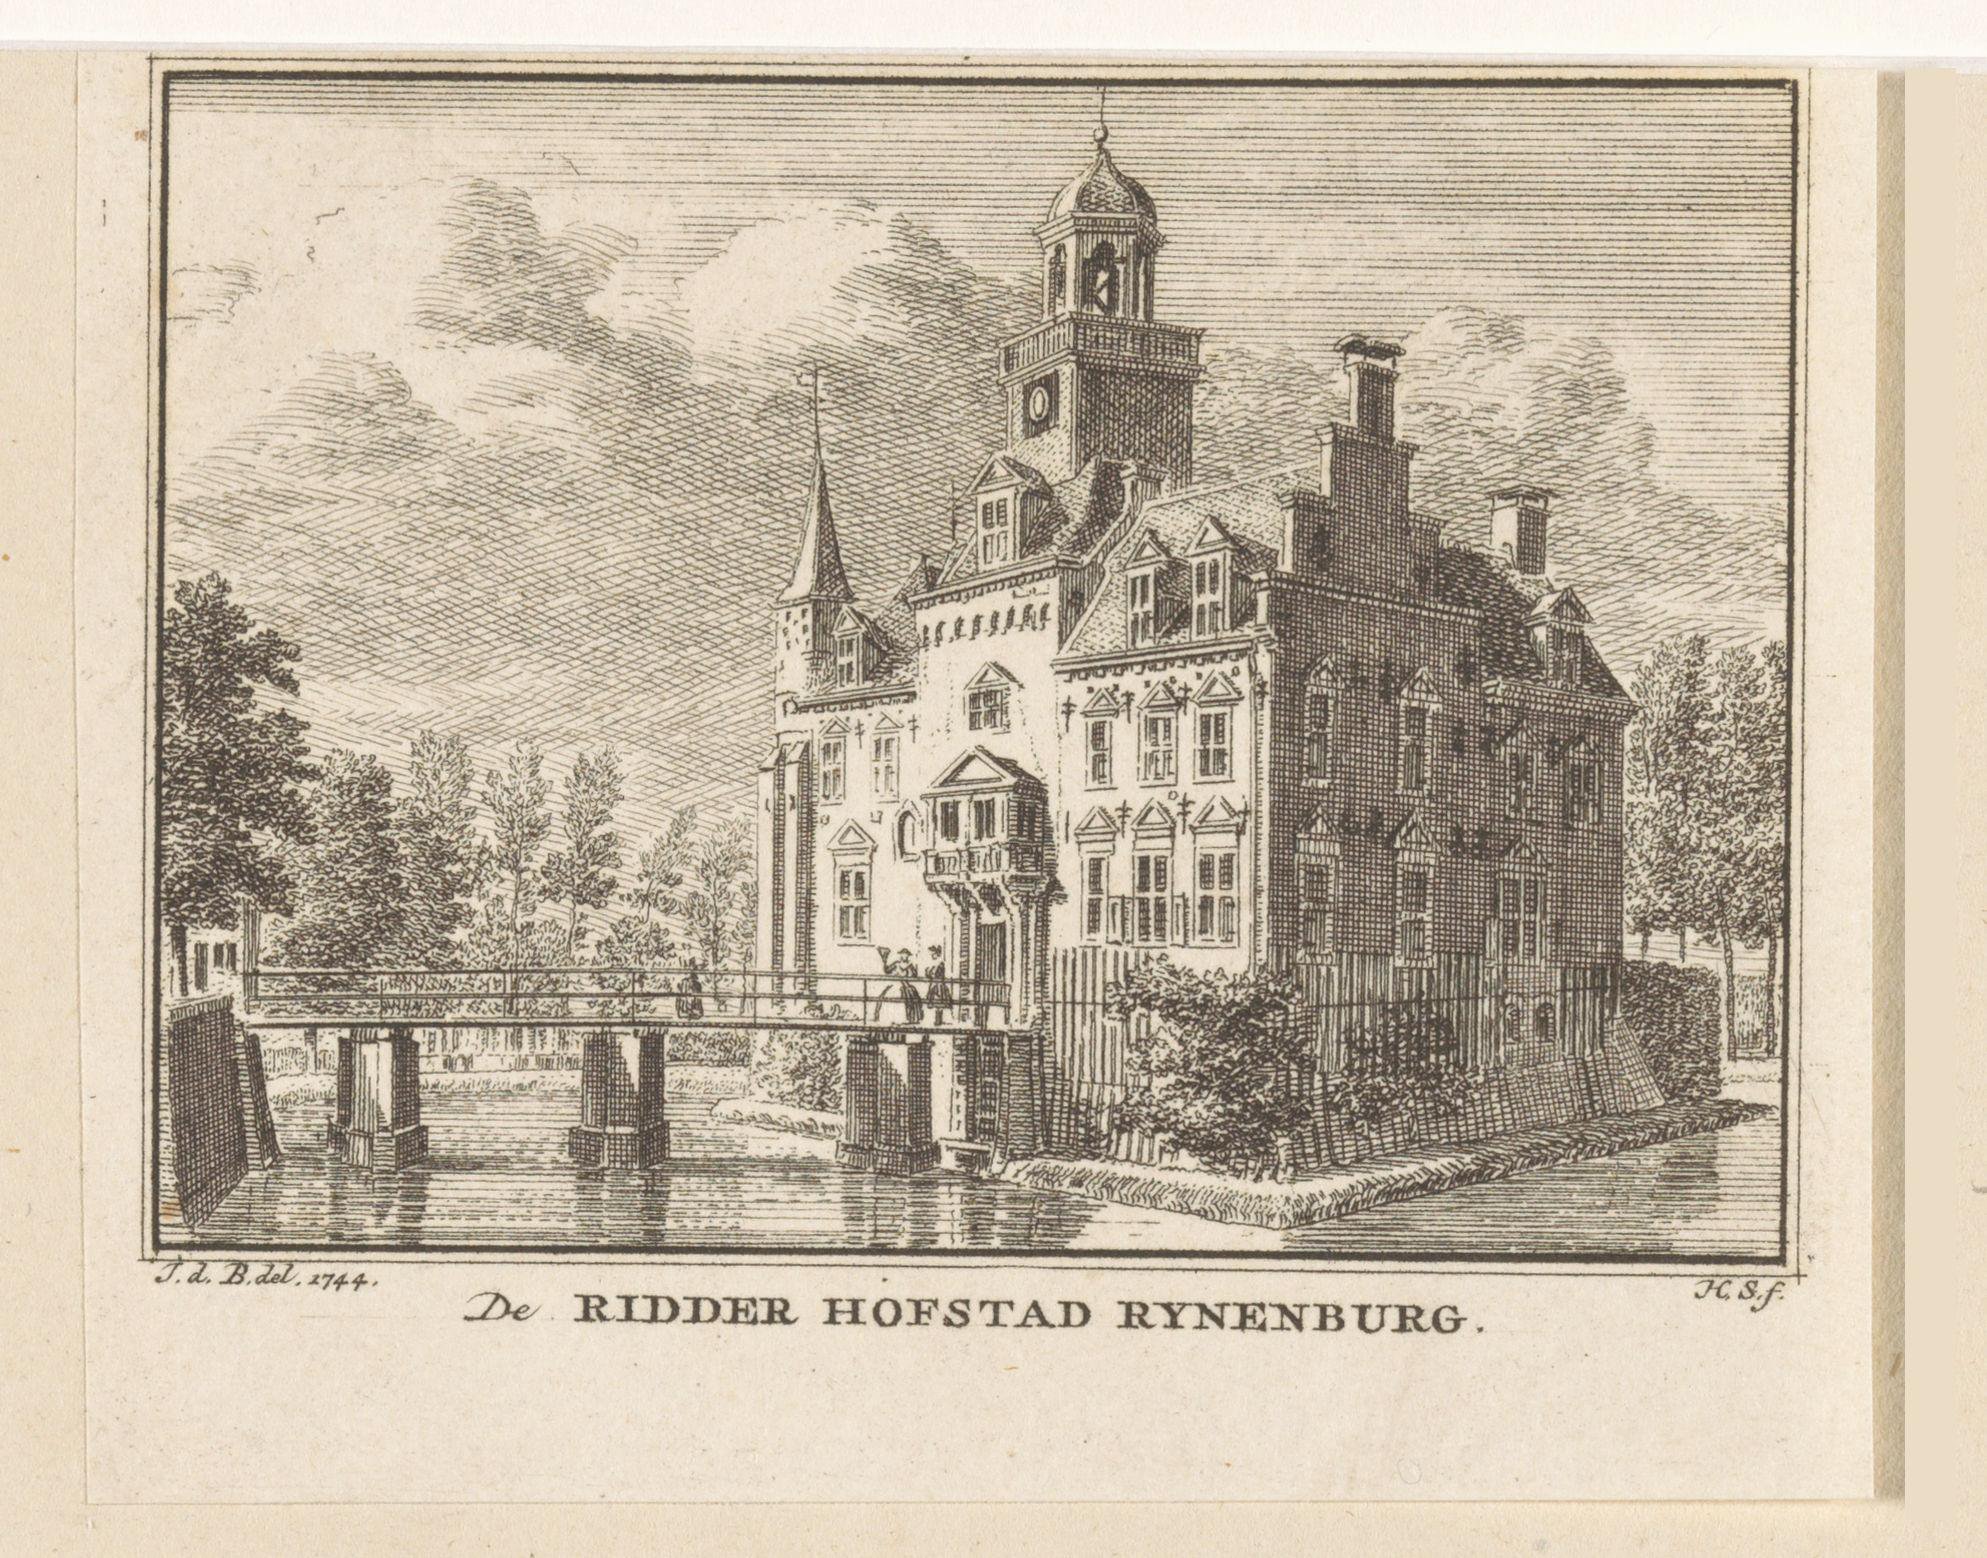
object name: book illustration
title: Gezicht op Kasteel Rijnenburg te Jutphaas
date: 1773-1792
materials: paper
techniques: engraving, etching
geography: haarlem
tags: castle, bridge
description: Prent ook gebruikt in: Het verheerlykt Nederland of kabinet van hedendaagsche gezigten van steden, dorpen (…). 9 delen. Amsterdam: Isaak Tirion en weduwe Isaak Tirion, 1745-1774, dl. 7, 8 of 9 (weduwe Isaak Tirion, 1773-1774), ill. 76. Of in: Nederlandsche tafereelen; of eene keurige verzameling van negen honderd fraaije gezigten van steden, dorpen, sloten, oudheden (….). 9 delen. Amsterdam: Jan de Groot, 1792, dl. 7, 8 of 9, ill. 76. Uit welke druk het huidige exemplaar precies komt is niet na te gaan.